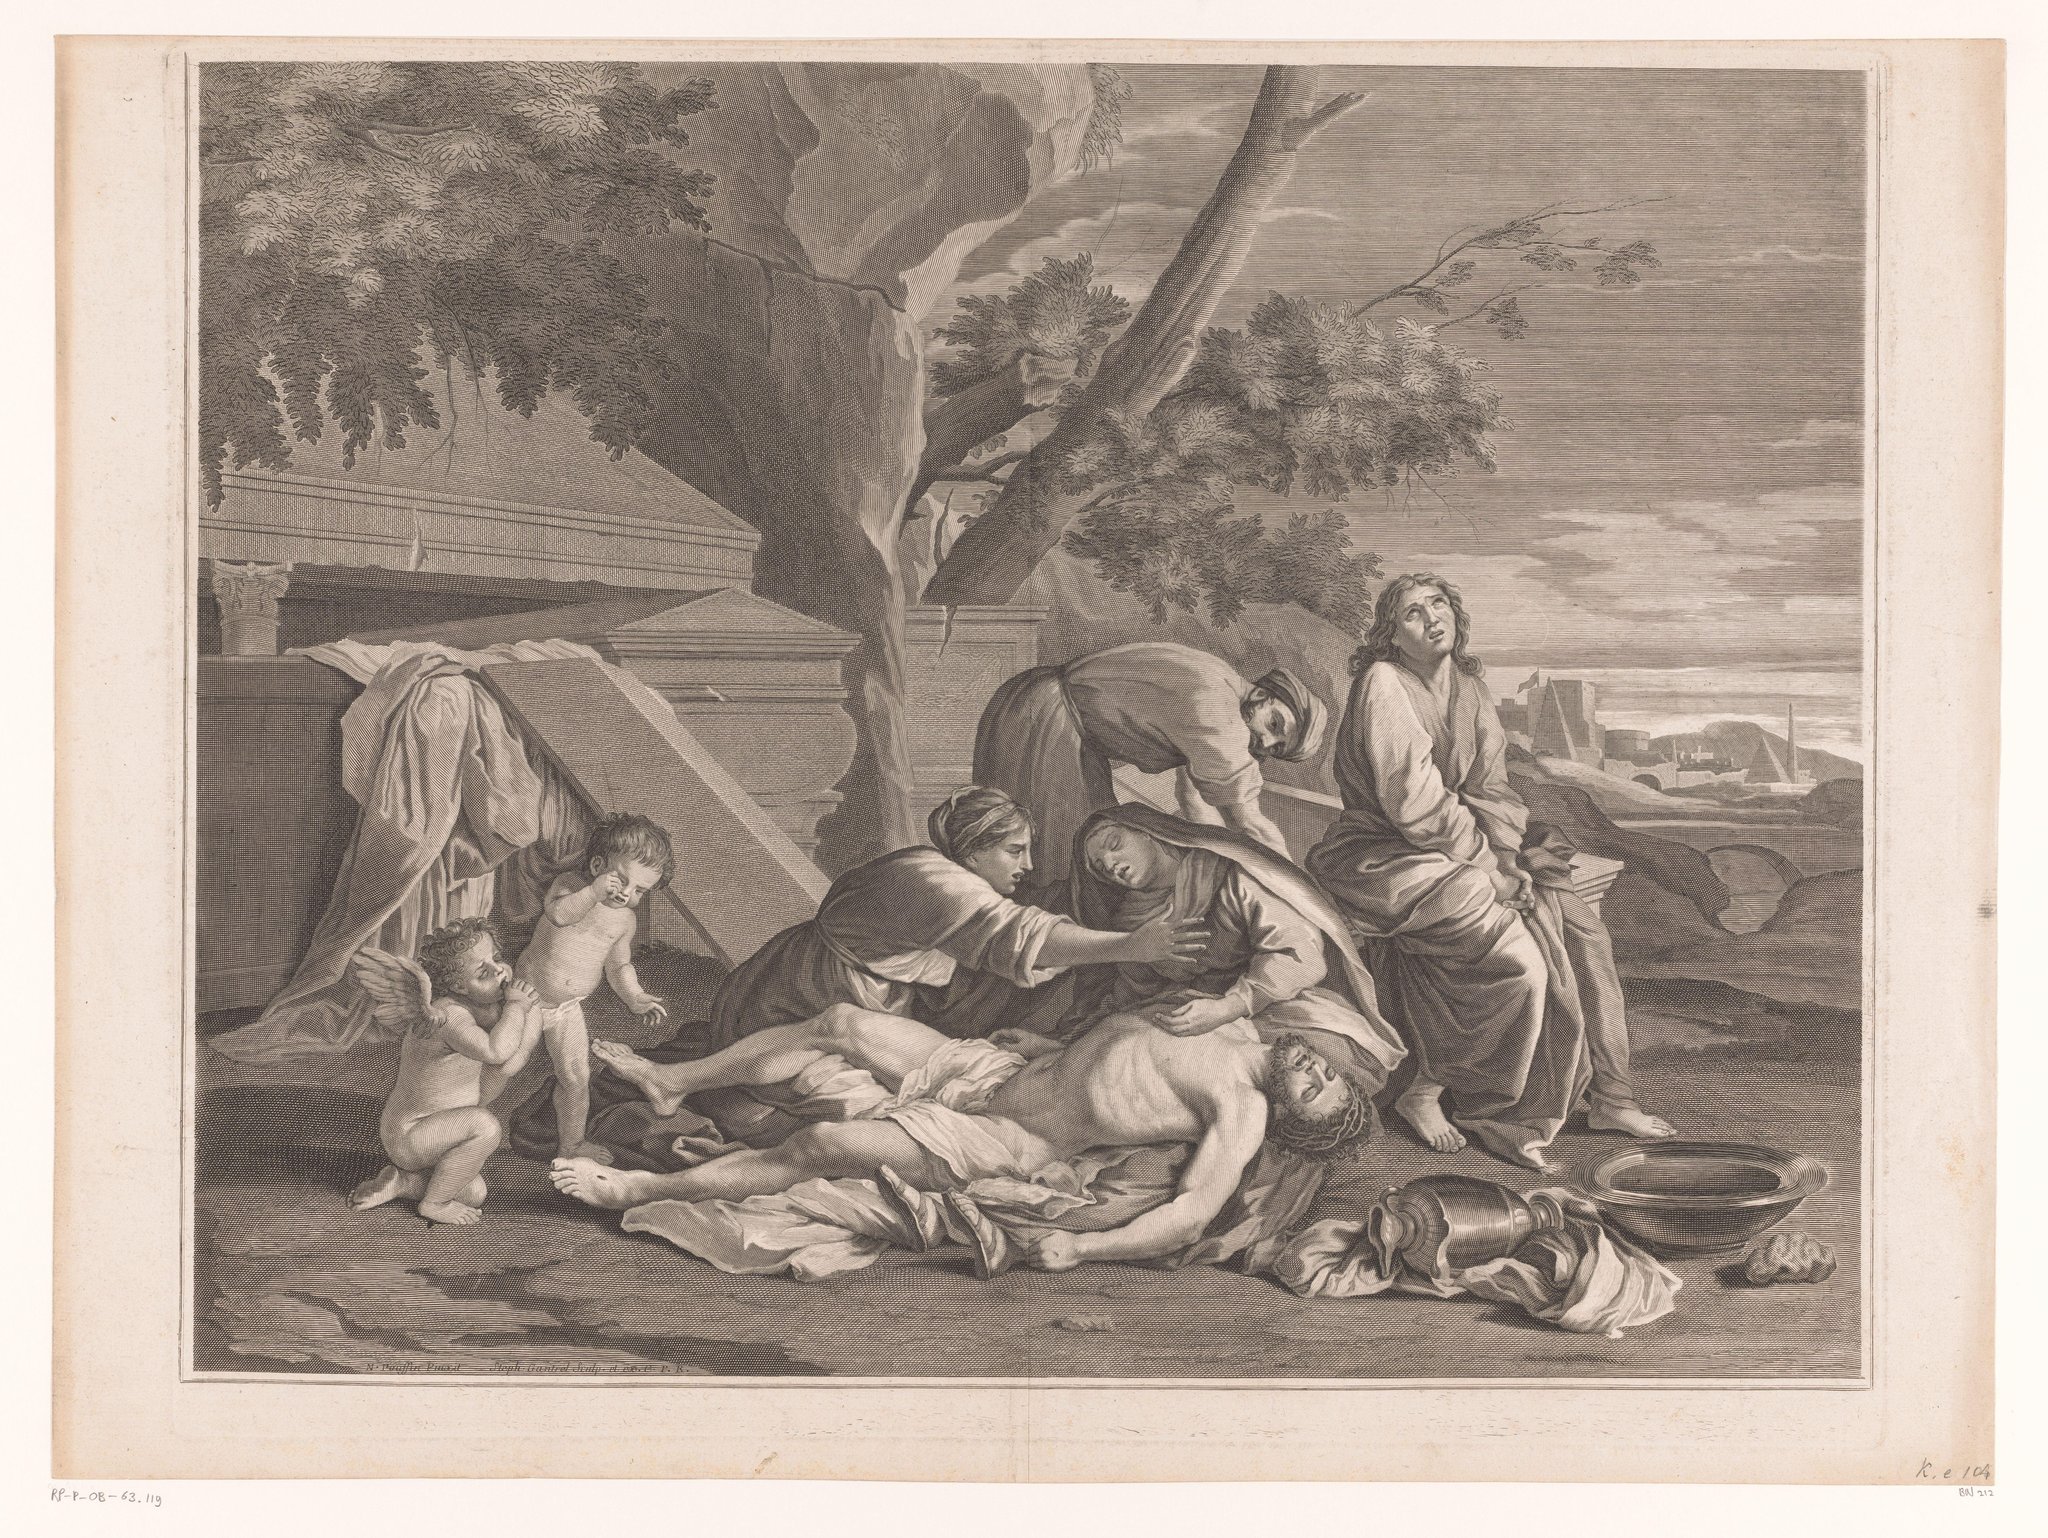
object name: print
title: Graflegging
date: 1656-1706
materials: paper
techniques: engraving, etching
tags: christ's entombment (possibly by angels)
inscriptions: number: ‘32’, collector's mark: Lugt 240